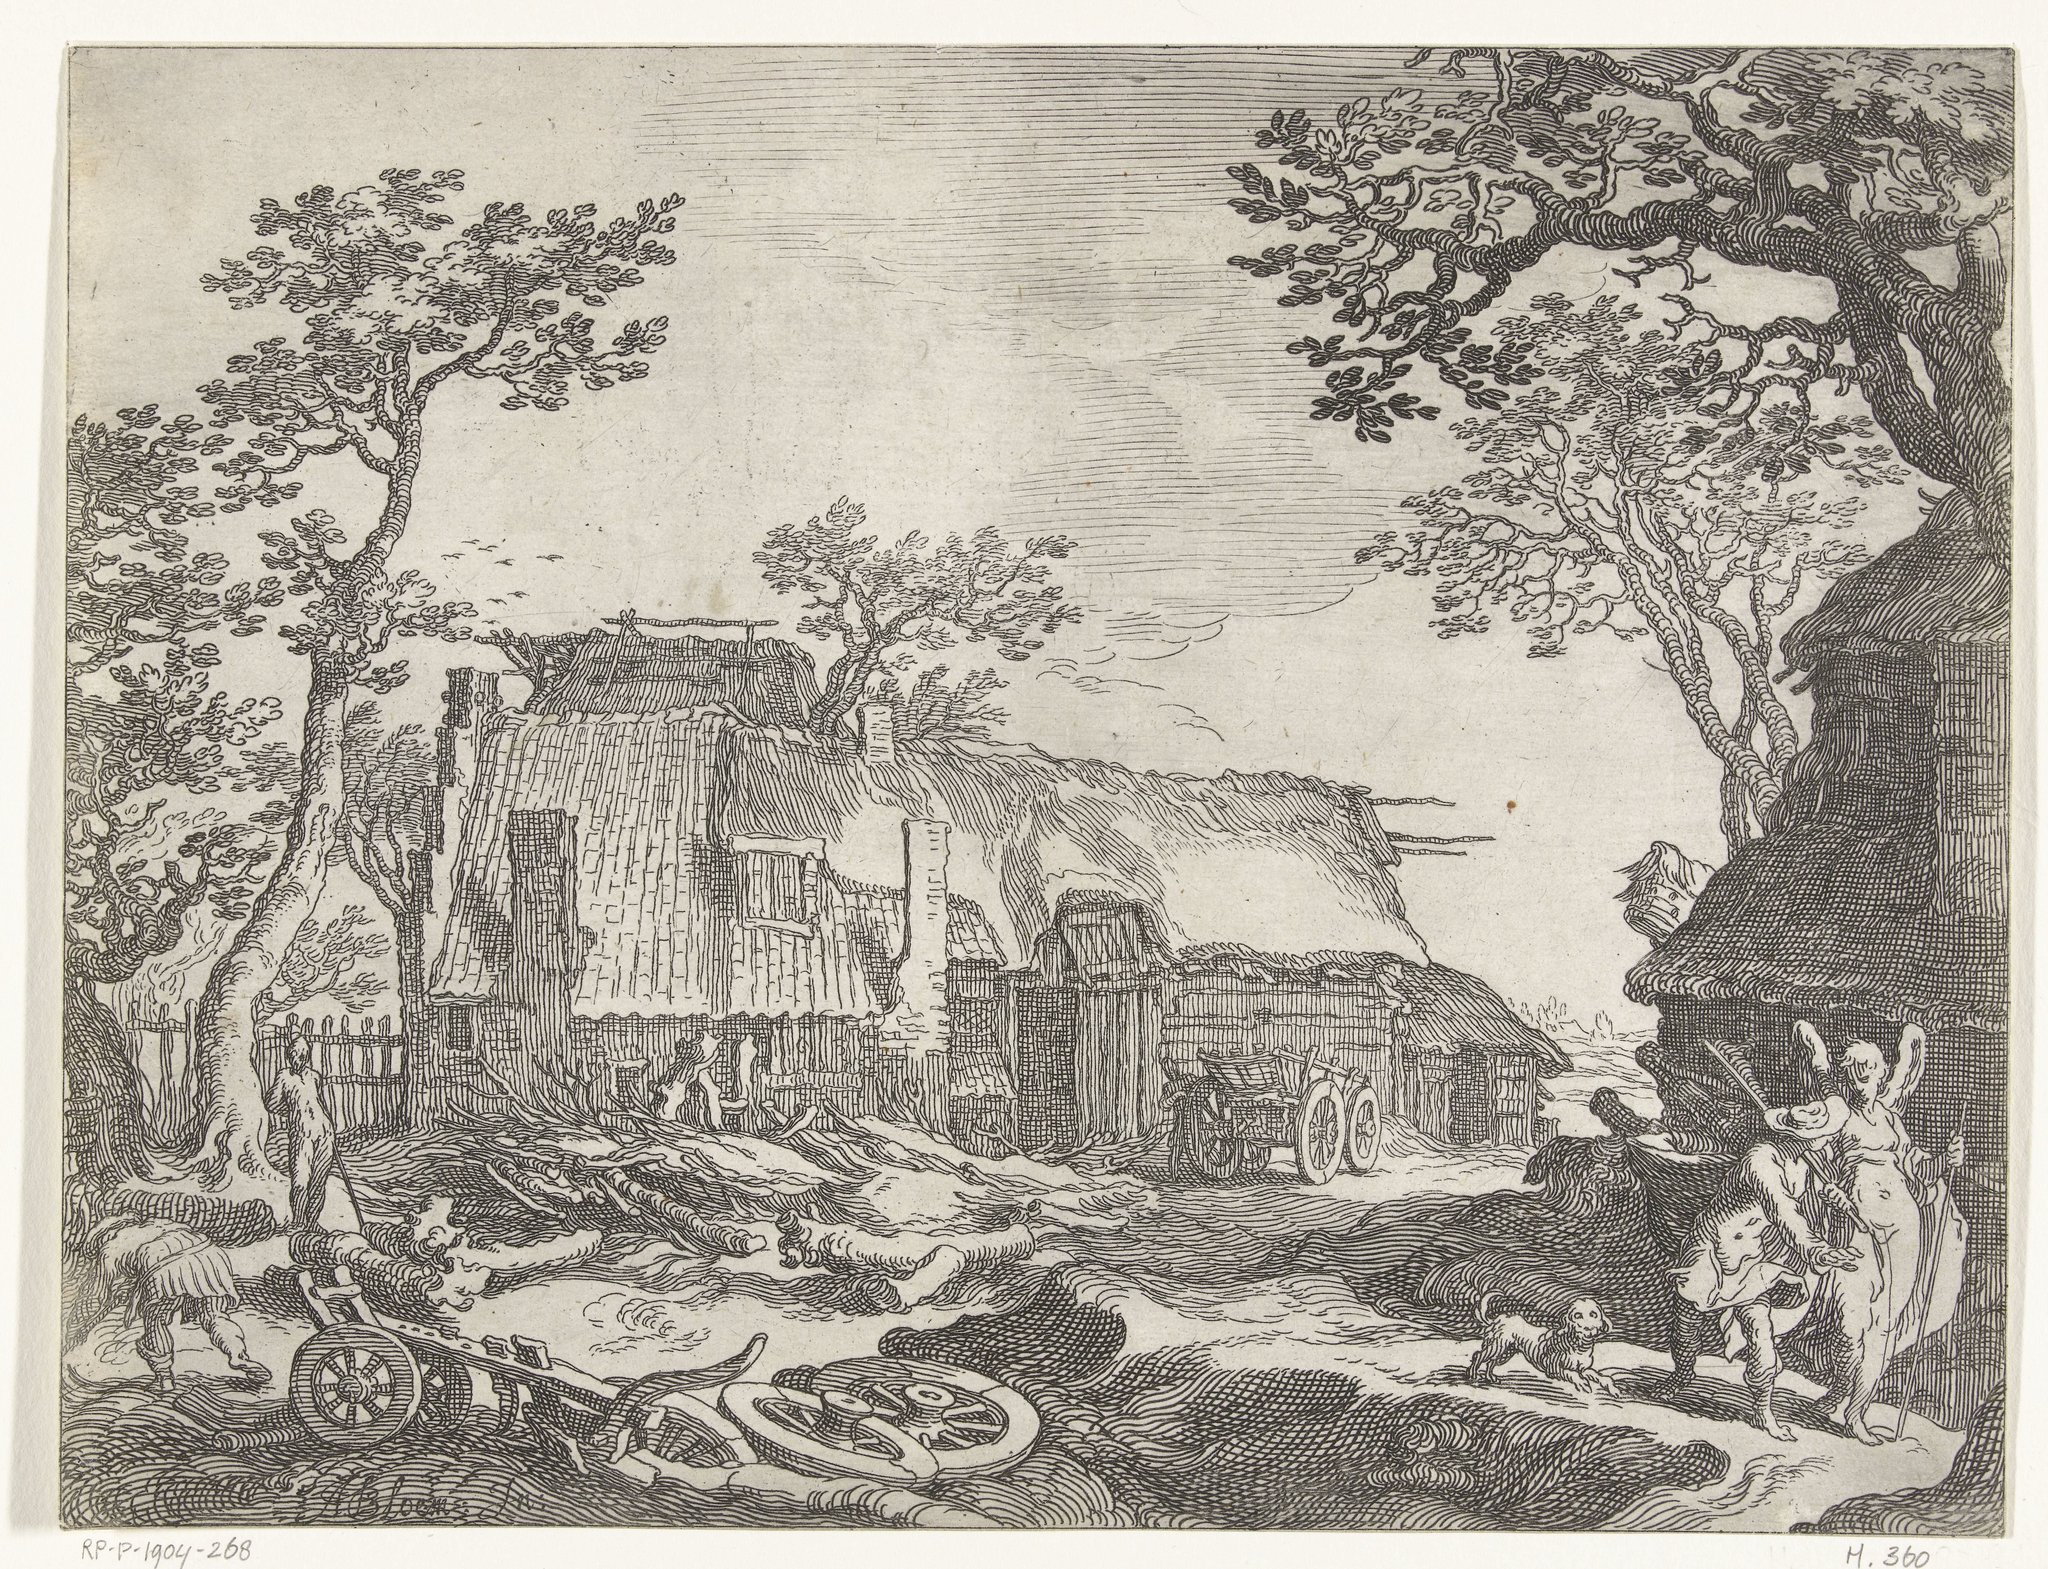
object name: print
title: Landschap met boerderij en Tobias en de engel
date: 1612-1614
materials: paper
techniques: etching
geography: amsterdam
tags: tobias and the angel raphael travelling, accompanied by tobias' dog, farm or solitary house in landscape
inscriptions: collector's mark: Lugt 2228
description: Prent uit serie van vier Gezichten op het platteland naar ontwerp van Abraham Bloemaert.